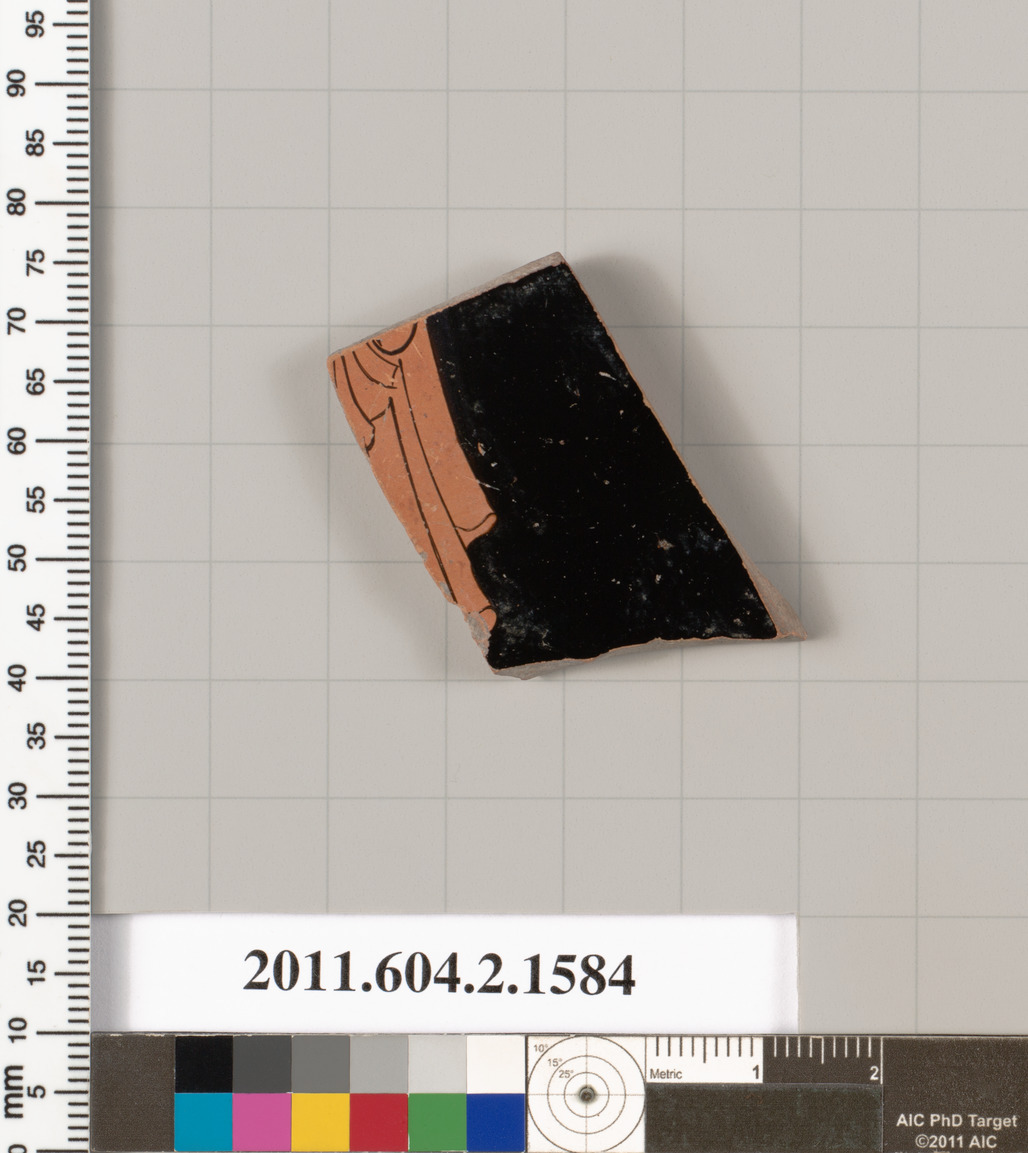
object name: skyphos fragment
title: Terracotta fragment of a skyphos (deep drinking cup)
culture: greek, attic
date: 480-470 BCE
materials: terracotta